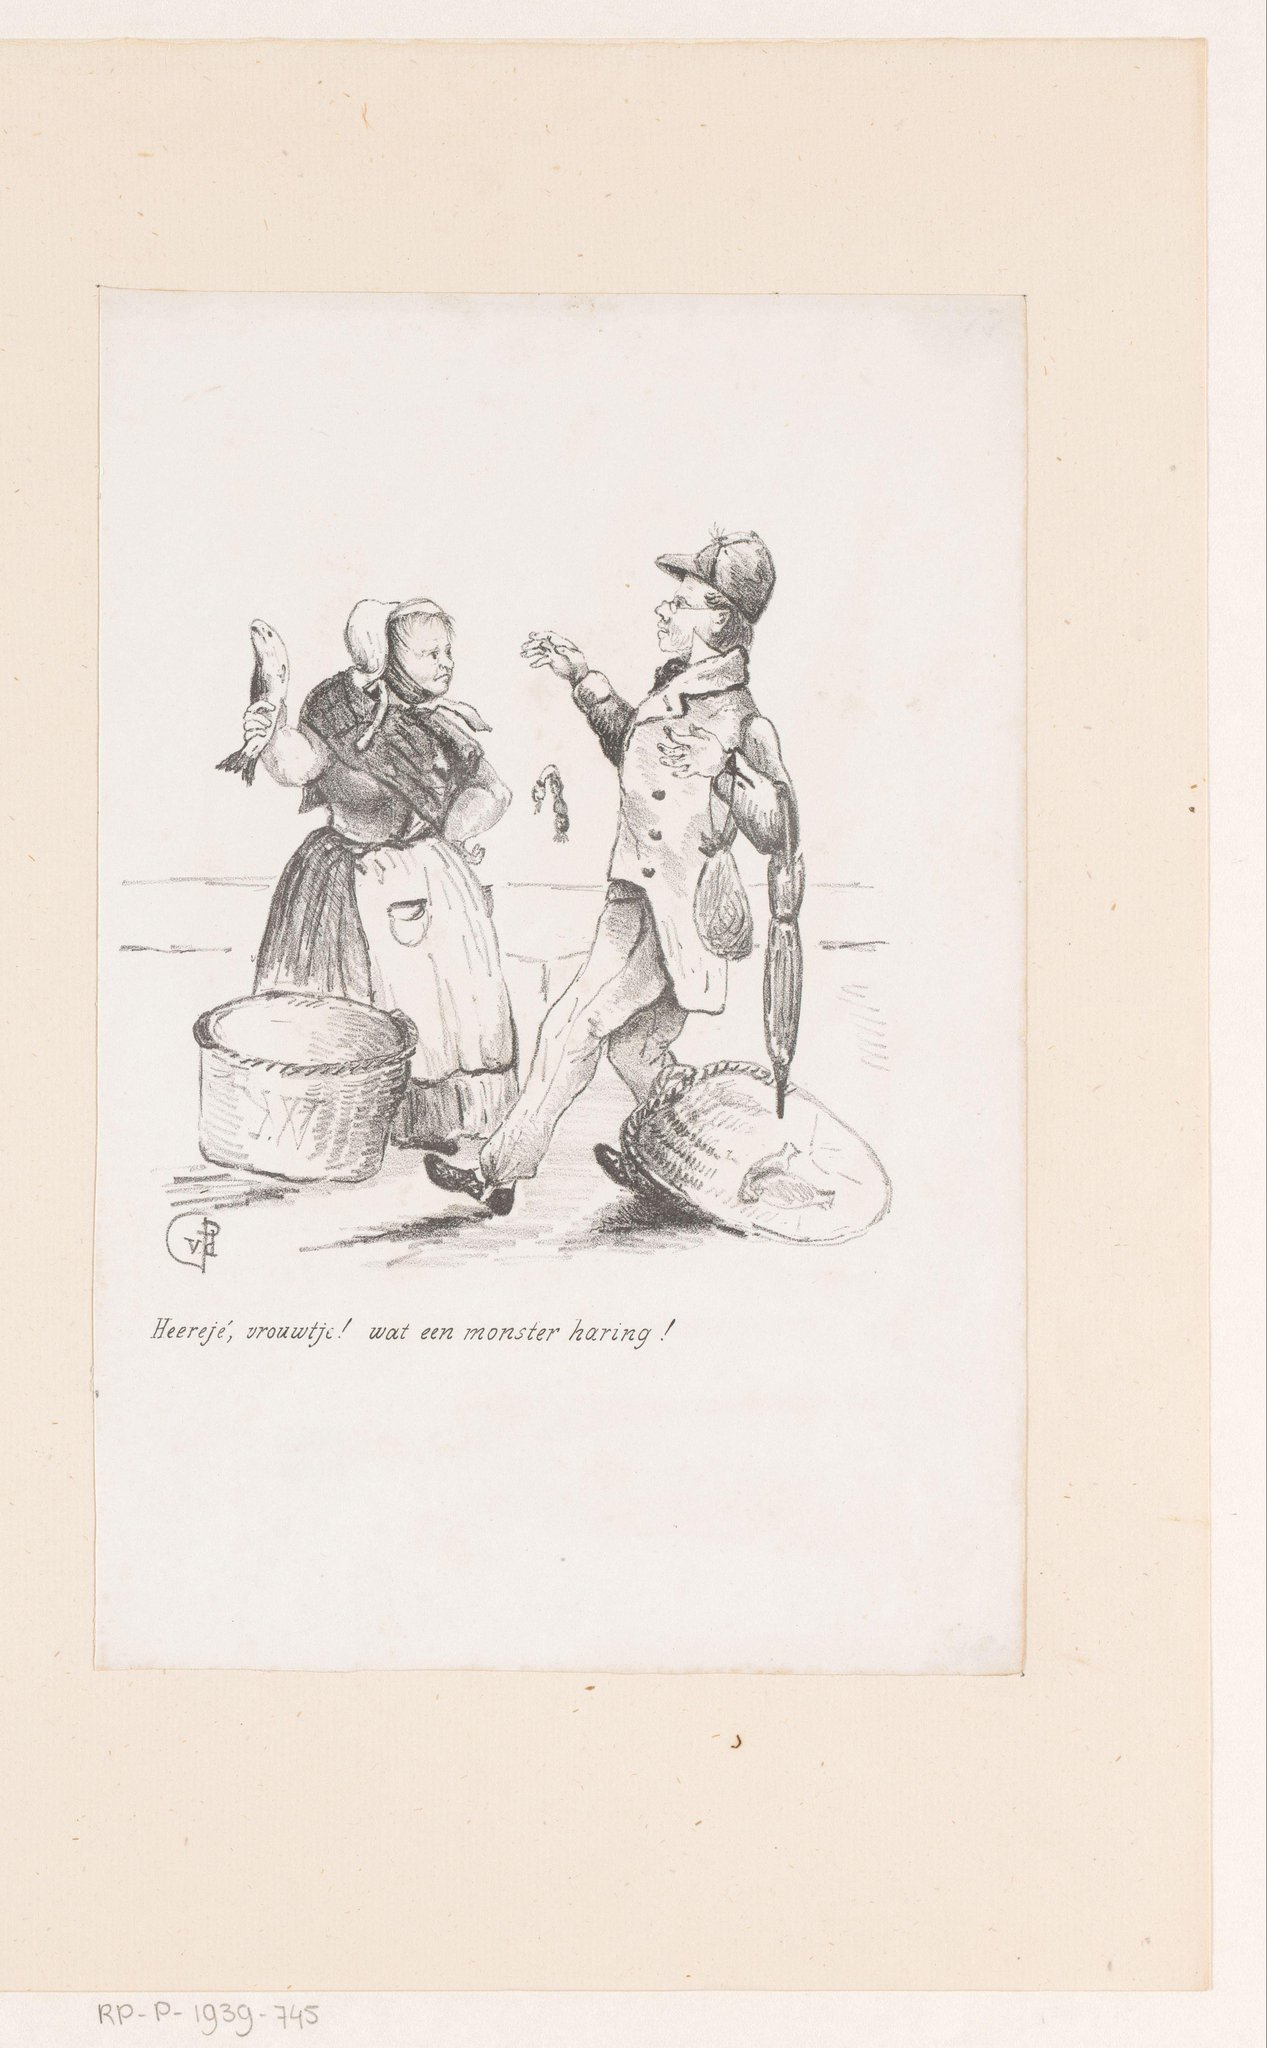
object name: print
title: Losse schetsen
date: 1864-1902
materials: paper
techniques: lithograph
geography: netherlands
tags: bony fishes: herring, fisherman showing catch, anxiety, solicitude; 'sollecitudine' (ripa)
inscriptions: collector's mark: Lugt 2760, collector's mark: Lugt 2166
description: Een man met paraplu en pet deinst verschrikt achteruit na het zien van de grote haring die de vissersvrouw voor hem uit de mand haalt.